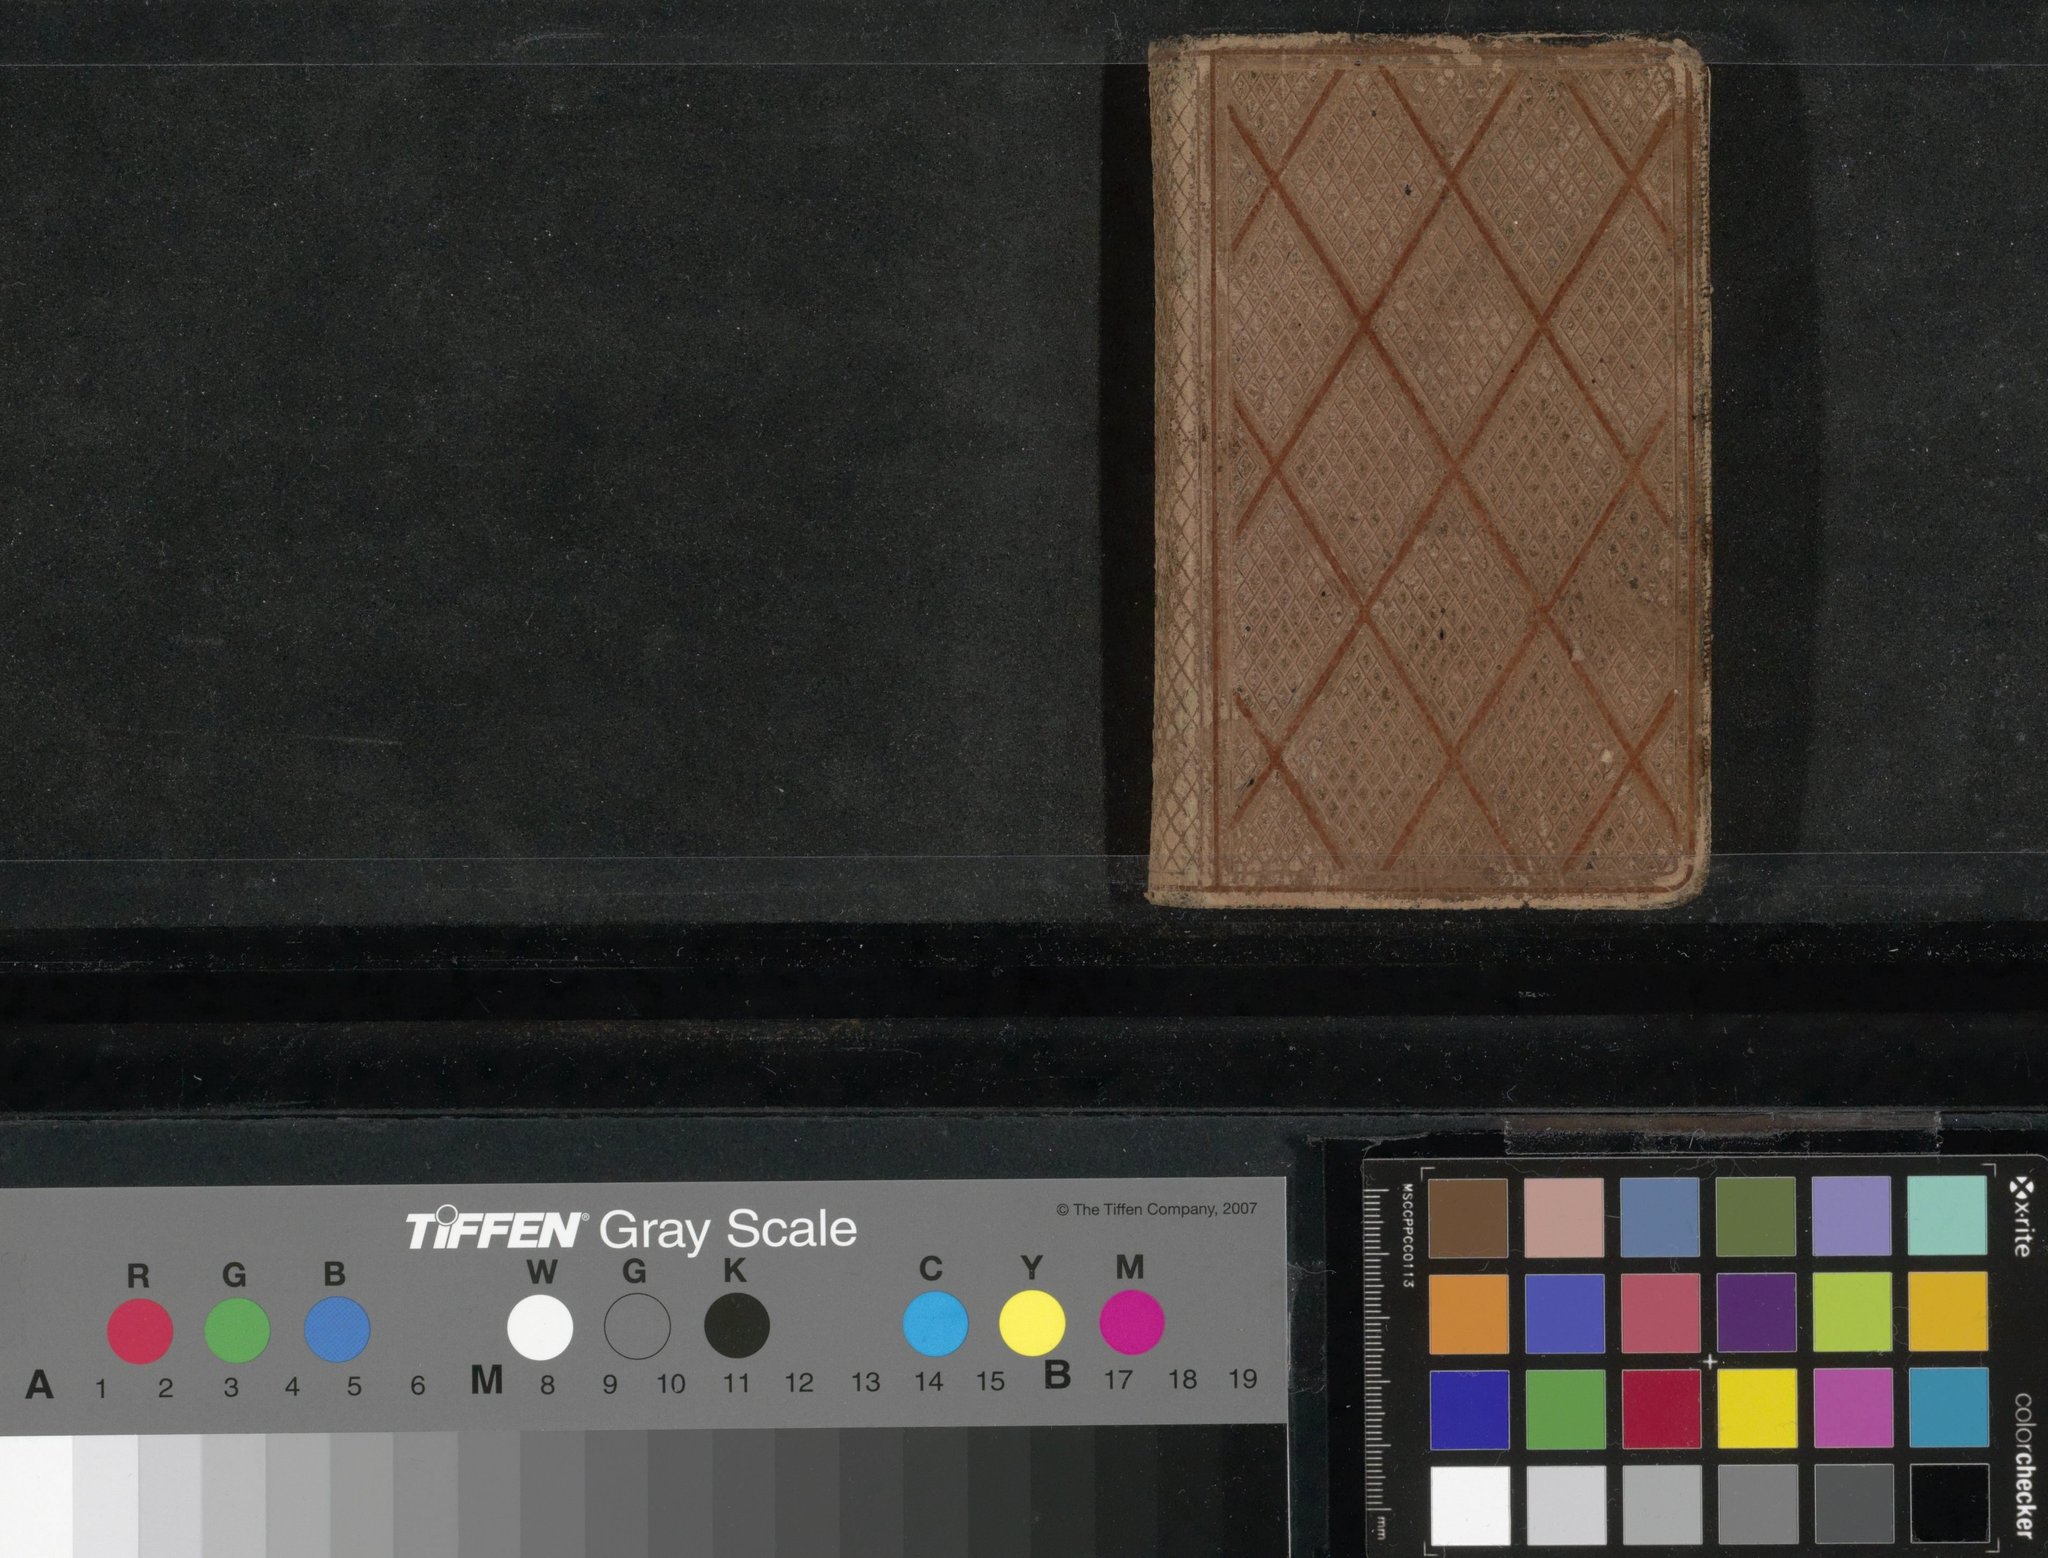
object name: sketchbook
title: Schetsboek met 58 bladen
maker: marius bauer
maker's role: draughtsman, print maker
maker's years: 1867-1932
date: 1879-1885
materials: chalk, charcoal, leather, paper, pencil, watercolor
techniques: brush, pen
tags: landscapes, inn, coffee-house, public house, etc., historical costume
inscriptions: collector's mark: Lugt 2228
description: Schetsboek bestaande uit 58 bladen met voornamelijk figuurstudies van personen in historisch kostuum en cafébezoekers en enkele landschappen.